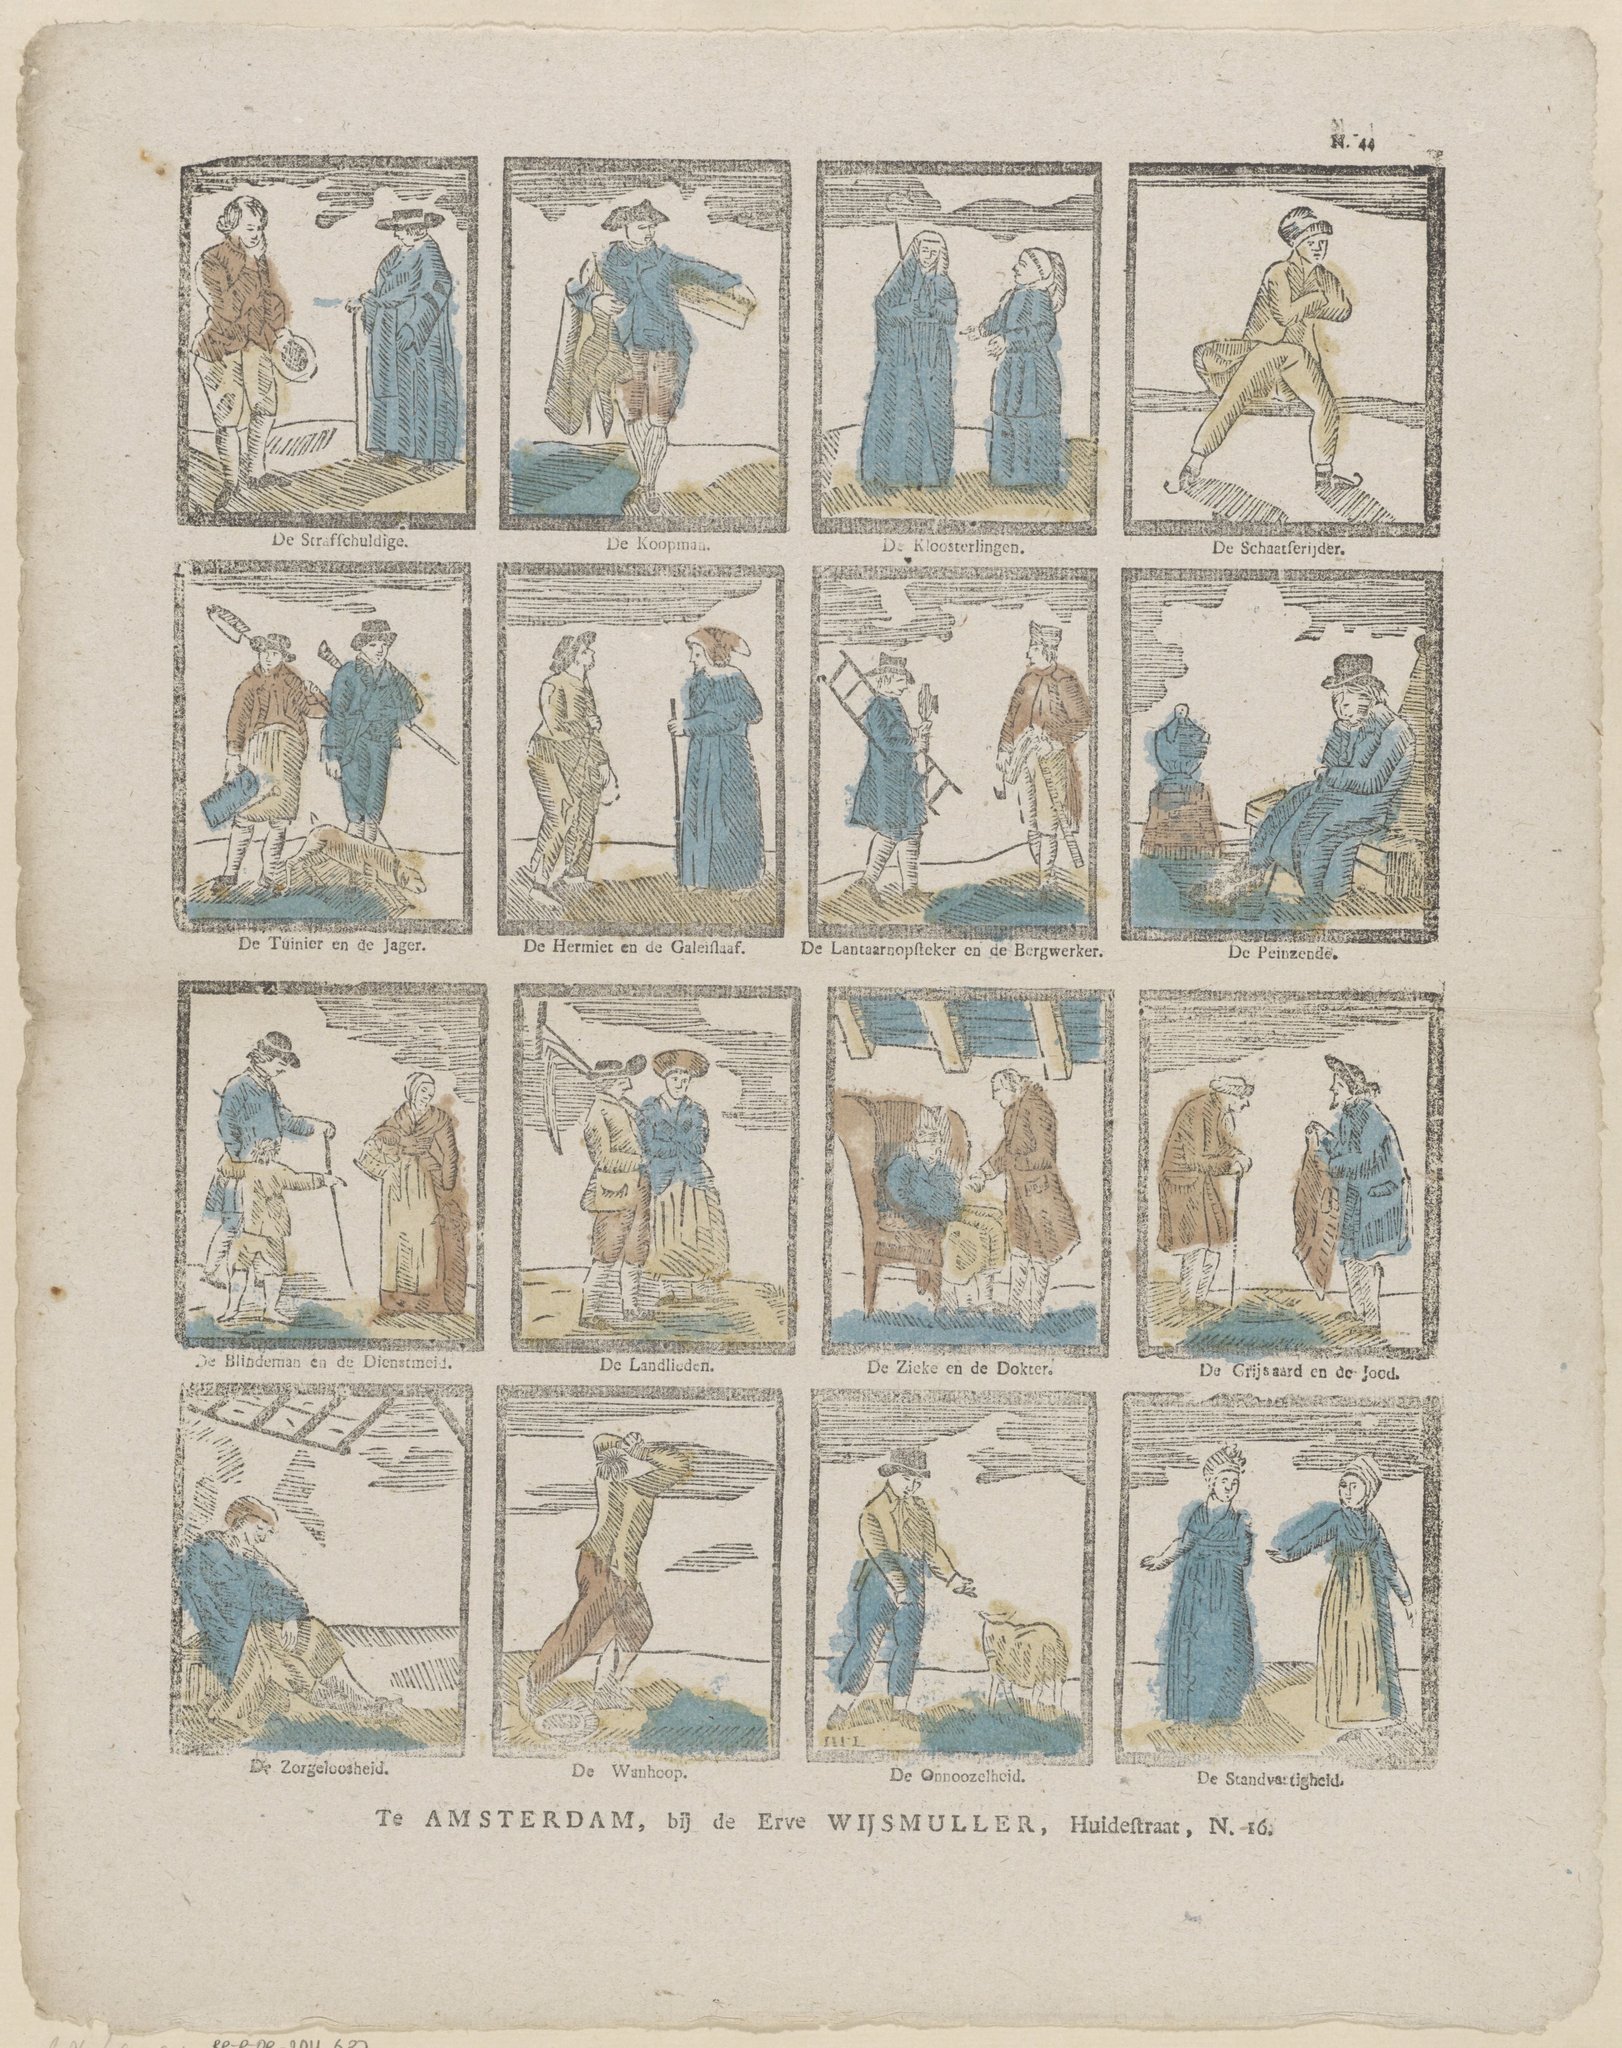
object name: popular print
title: Figuren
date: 1828-1849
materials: paper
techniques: colour, letterpress printing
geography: deventer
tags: human types, despair; 'disperatione' (ripa), working class, labourers, physician, doctor, constancy, tenacity; 'costanza', 'tenacità' (ripa), merchant, salesman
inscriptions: collector's mark: Lugt 2760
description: Blad met 16 voorstellingen van figuren, beroepen en verbeeldingen van onder andere de zorgeloosheid en de wanhoop. Onder elke afbeelding een onderschrift. Genummerd rechtsboven: N. 44.